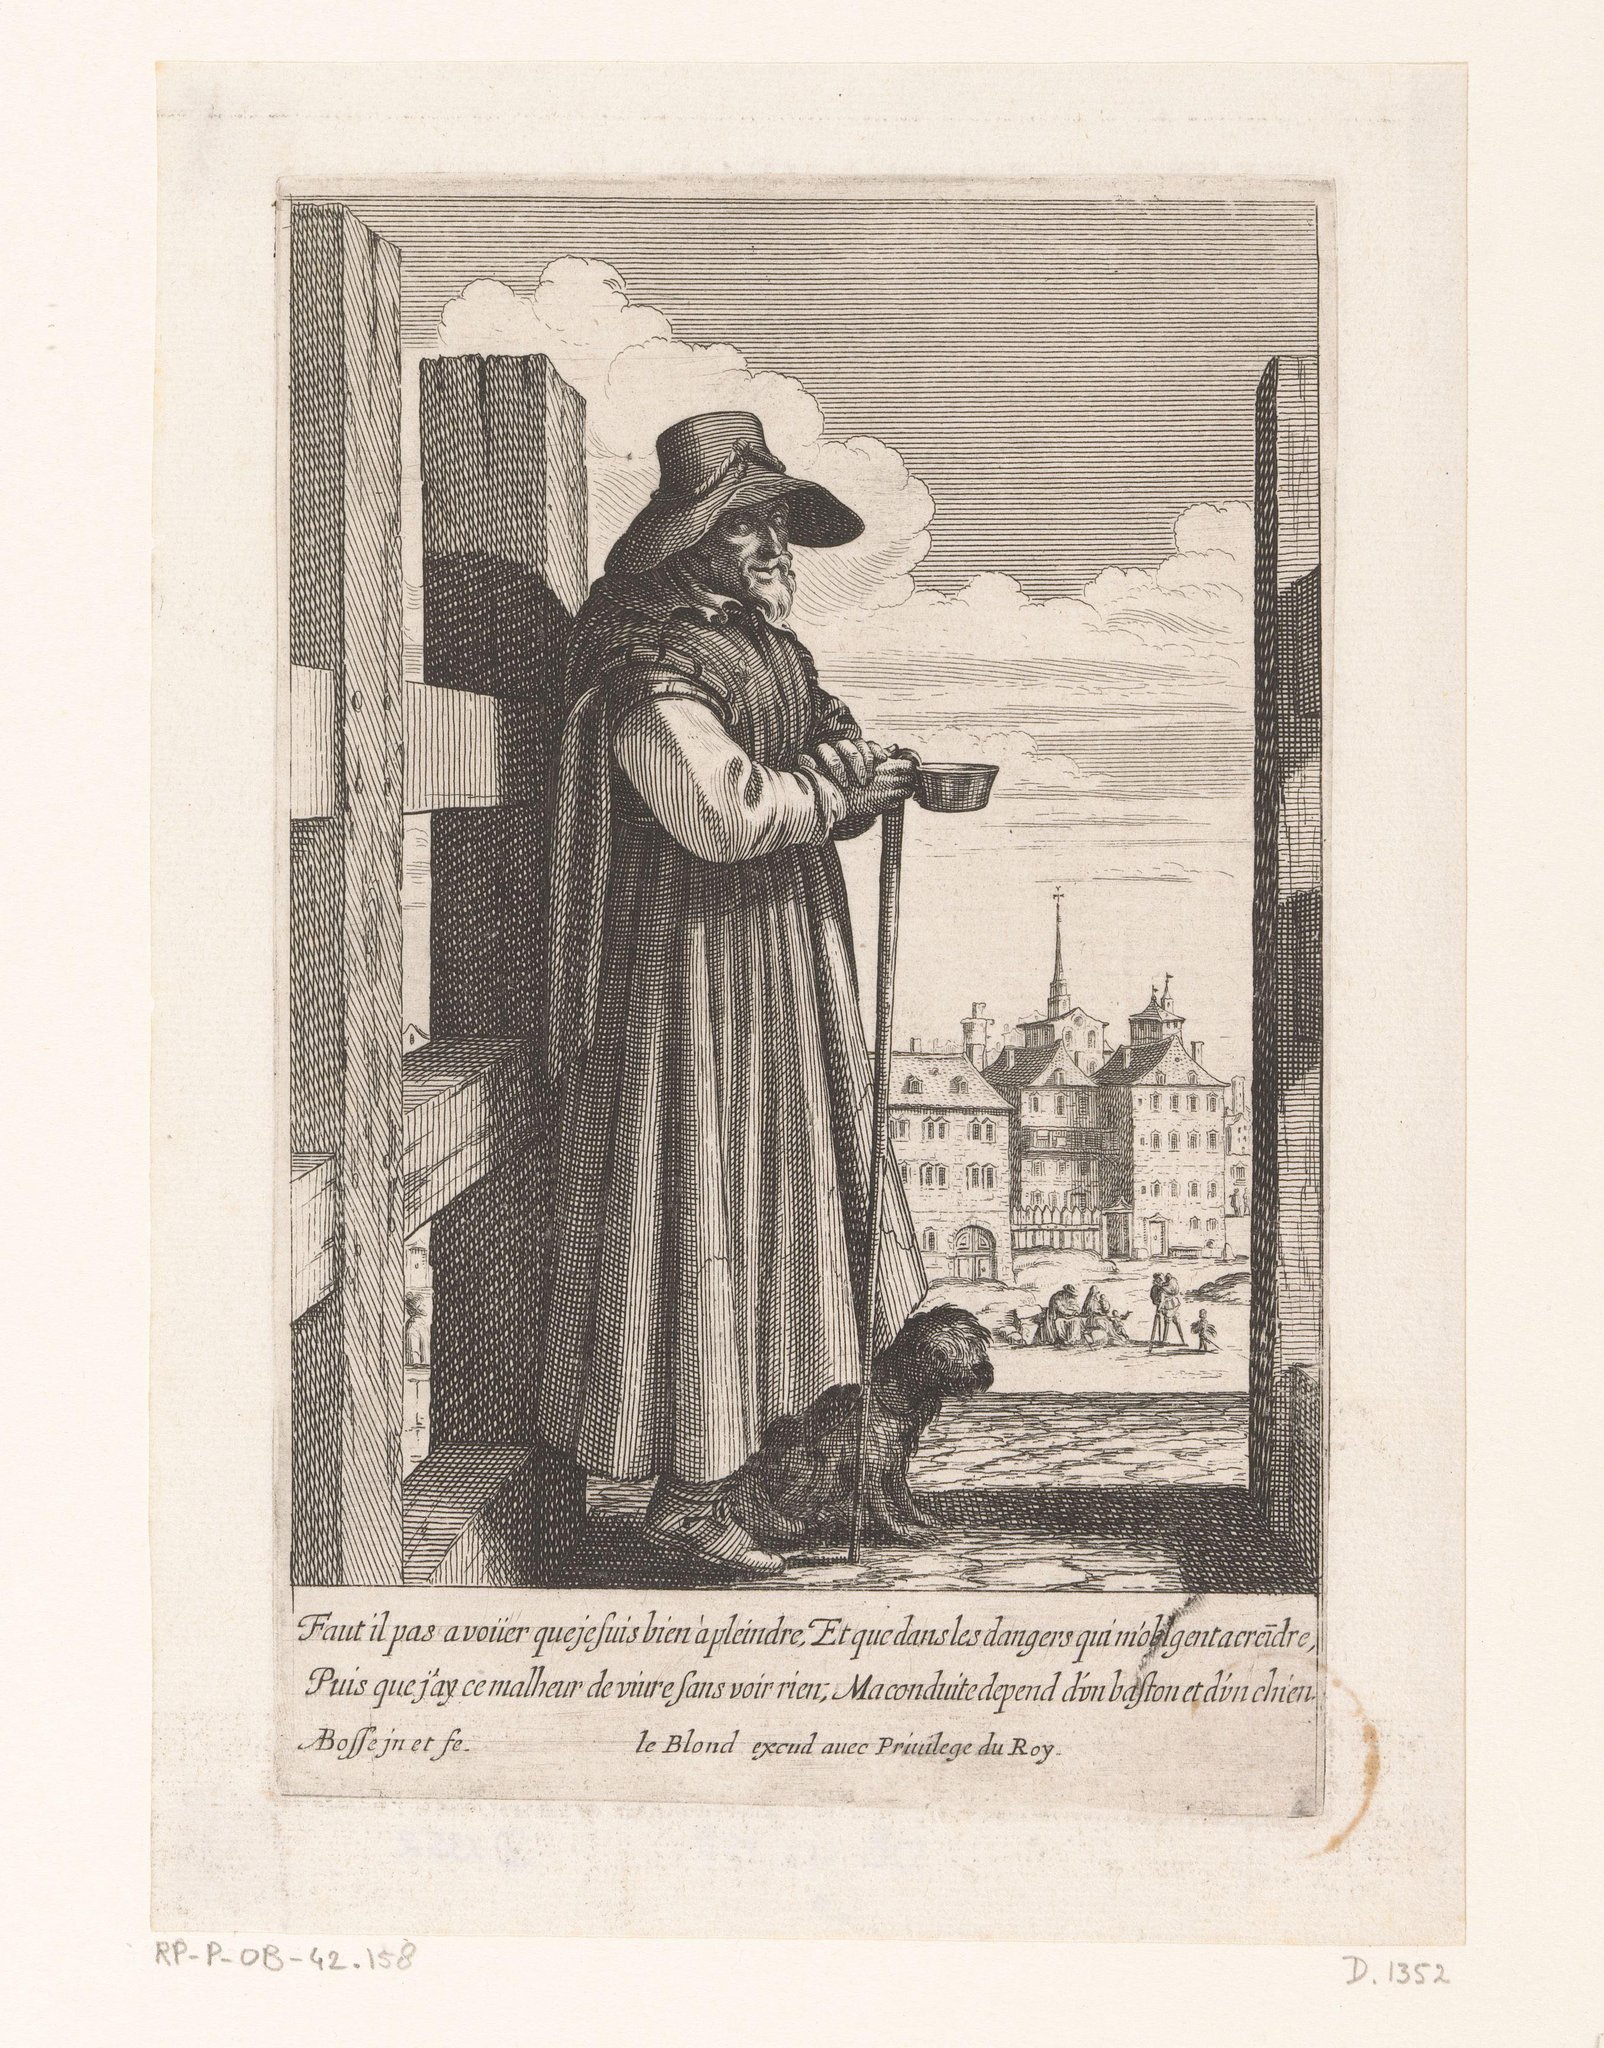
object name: print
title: Les cris de Paris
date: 1629-1630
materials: paper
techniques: engraving, etching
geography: paris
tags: blind, blindness, wandering or travelling merchant, beggar, merchant, salesman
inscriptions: collector's mark: Lugt 240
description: Maakt deel uit van een serie van twaalf prenten met straatverkopers en dienstverleners, uitgegeven door Jean Leblond (I) tussen 1629-1630 te Parijs.